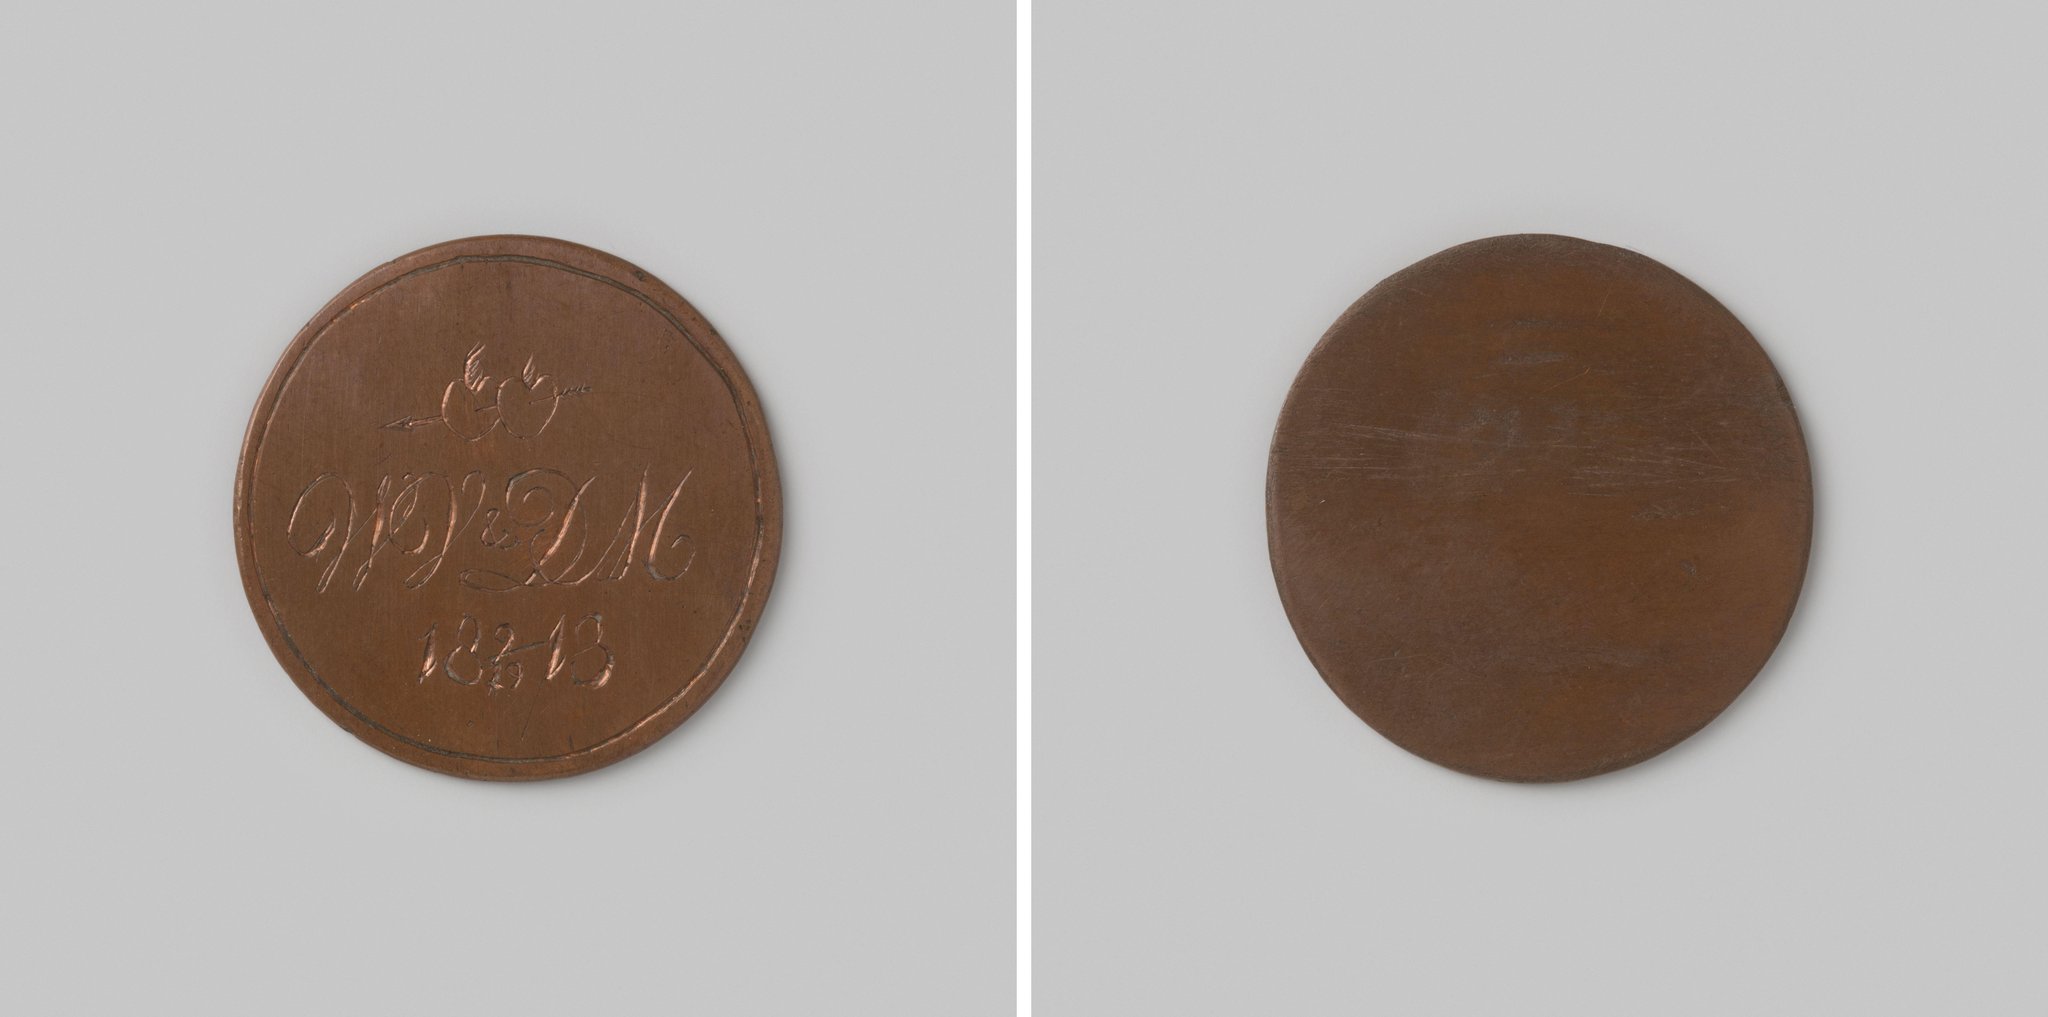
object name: coin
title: Zweedse koperen munt bewerkt tot penning op de verbindtenis van W.V. en D.M. op 19 september 1813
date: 1813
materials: copper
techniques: engraving, striking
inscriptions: inscription: ‘WV & DM / 18 9/19 13’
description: Koperen penning gemaakt van een gepolijste koperen munt, op de voorzijde gegraveerd de initialen en datum onder twee brandende harten, binnen een cirkel, op de keerzijde sporen van het oorspronkelijke muntbeeld (drie kronen).